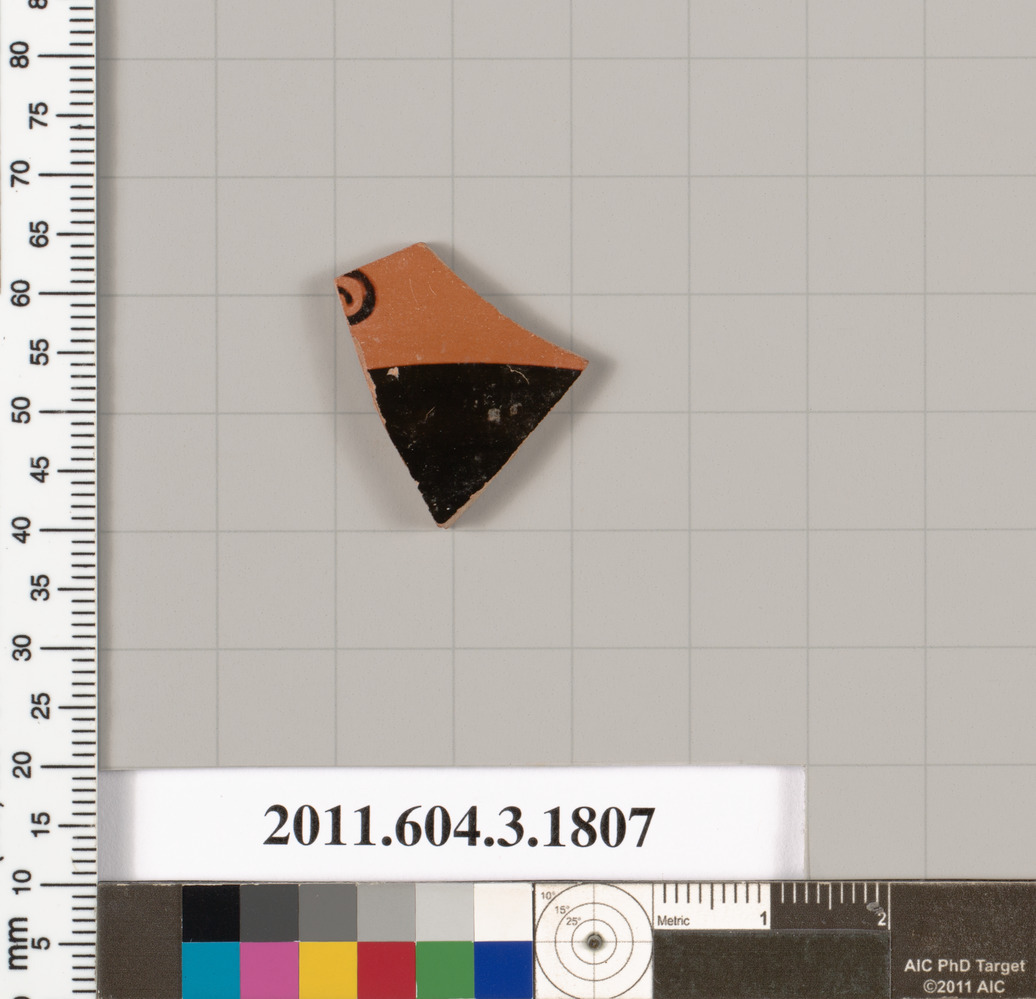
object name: kylix fragment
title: Terracotta fragment of a kylix: Lip cup (drinking cup)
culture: greek, attic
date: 550-526 BCE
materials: terracotta